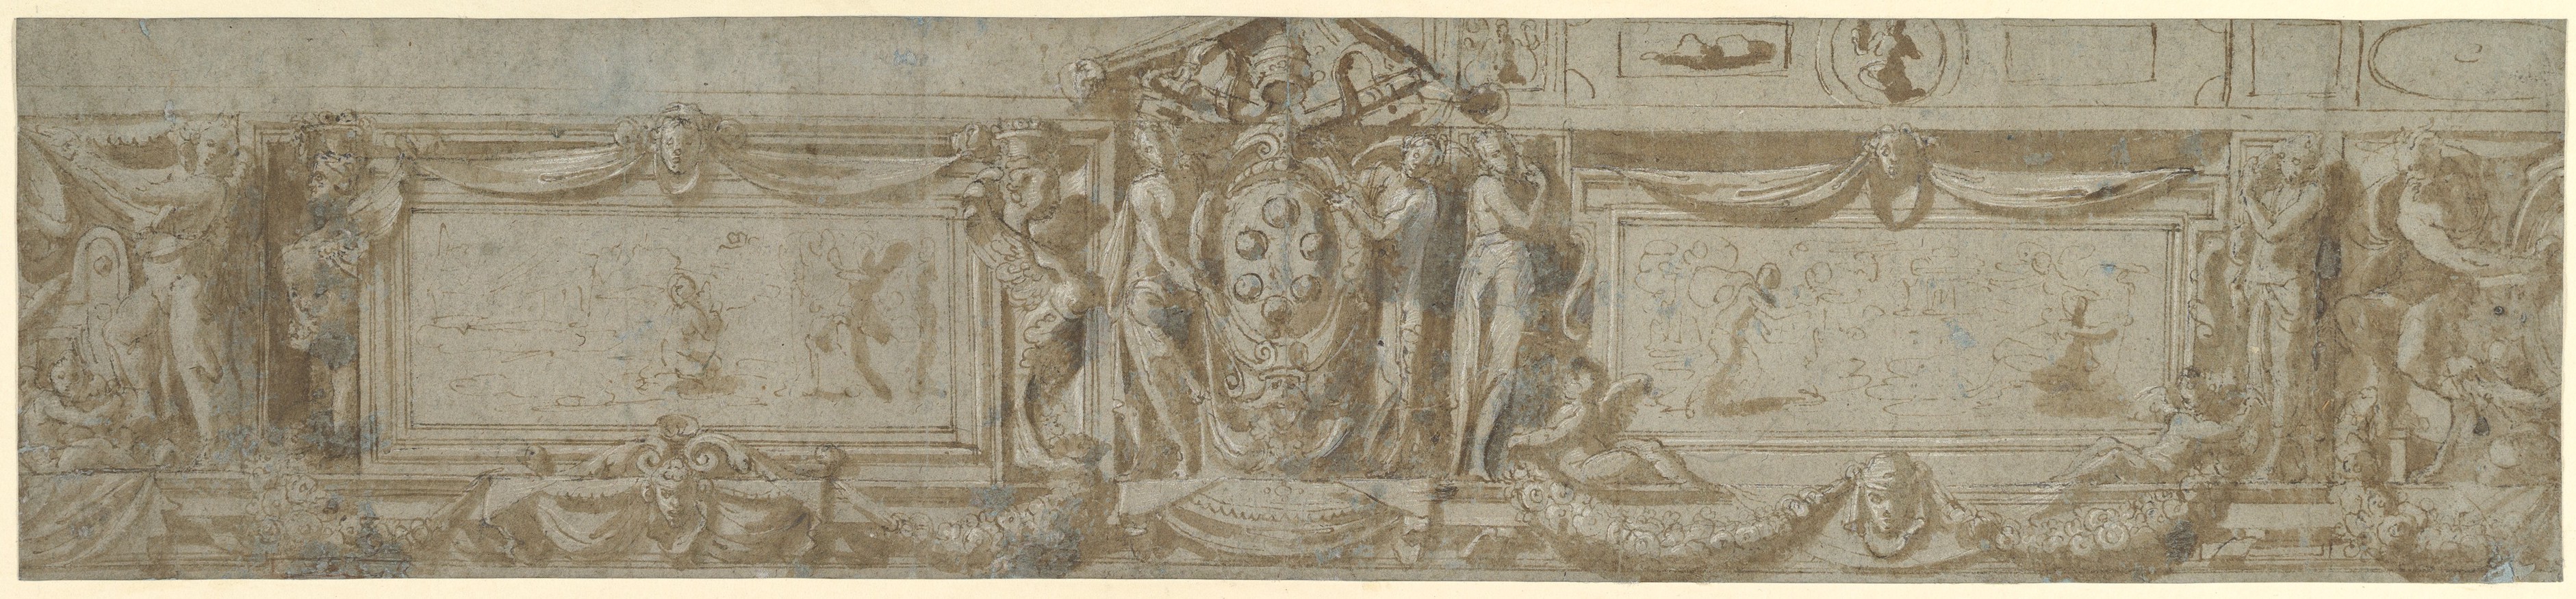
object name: drawing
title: Design for a Frieze with Central Cartouche Containing Medici Arms with Papal Tiara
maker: anonymous, italian, second half of the 16th century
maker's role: artist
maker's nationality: italian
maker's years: 1550-1600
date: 1550-1599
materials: ink, paper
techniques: highlighting, pen, wash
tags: coat of arms